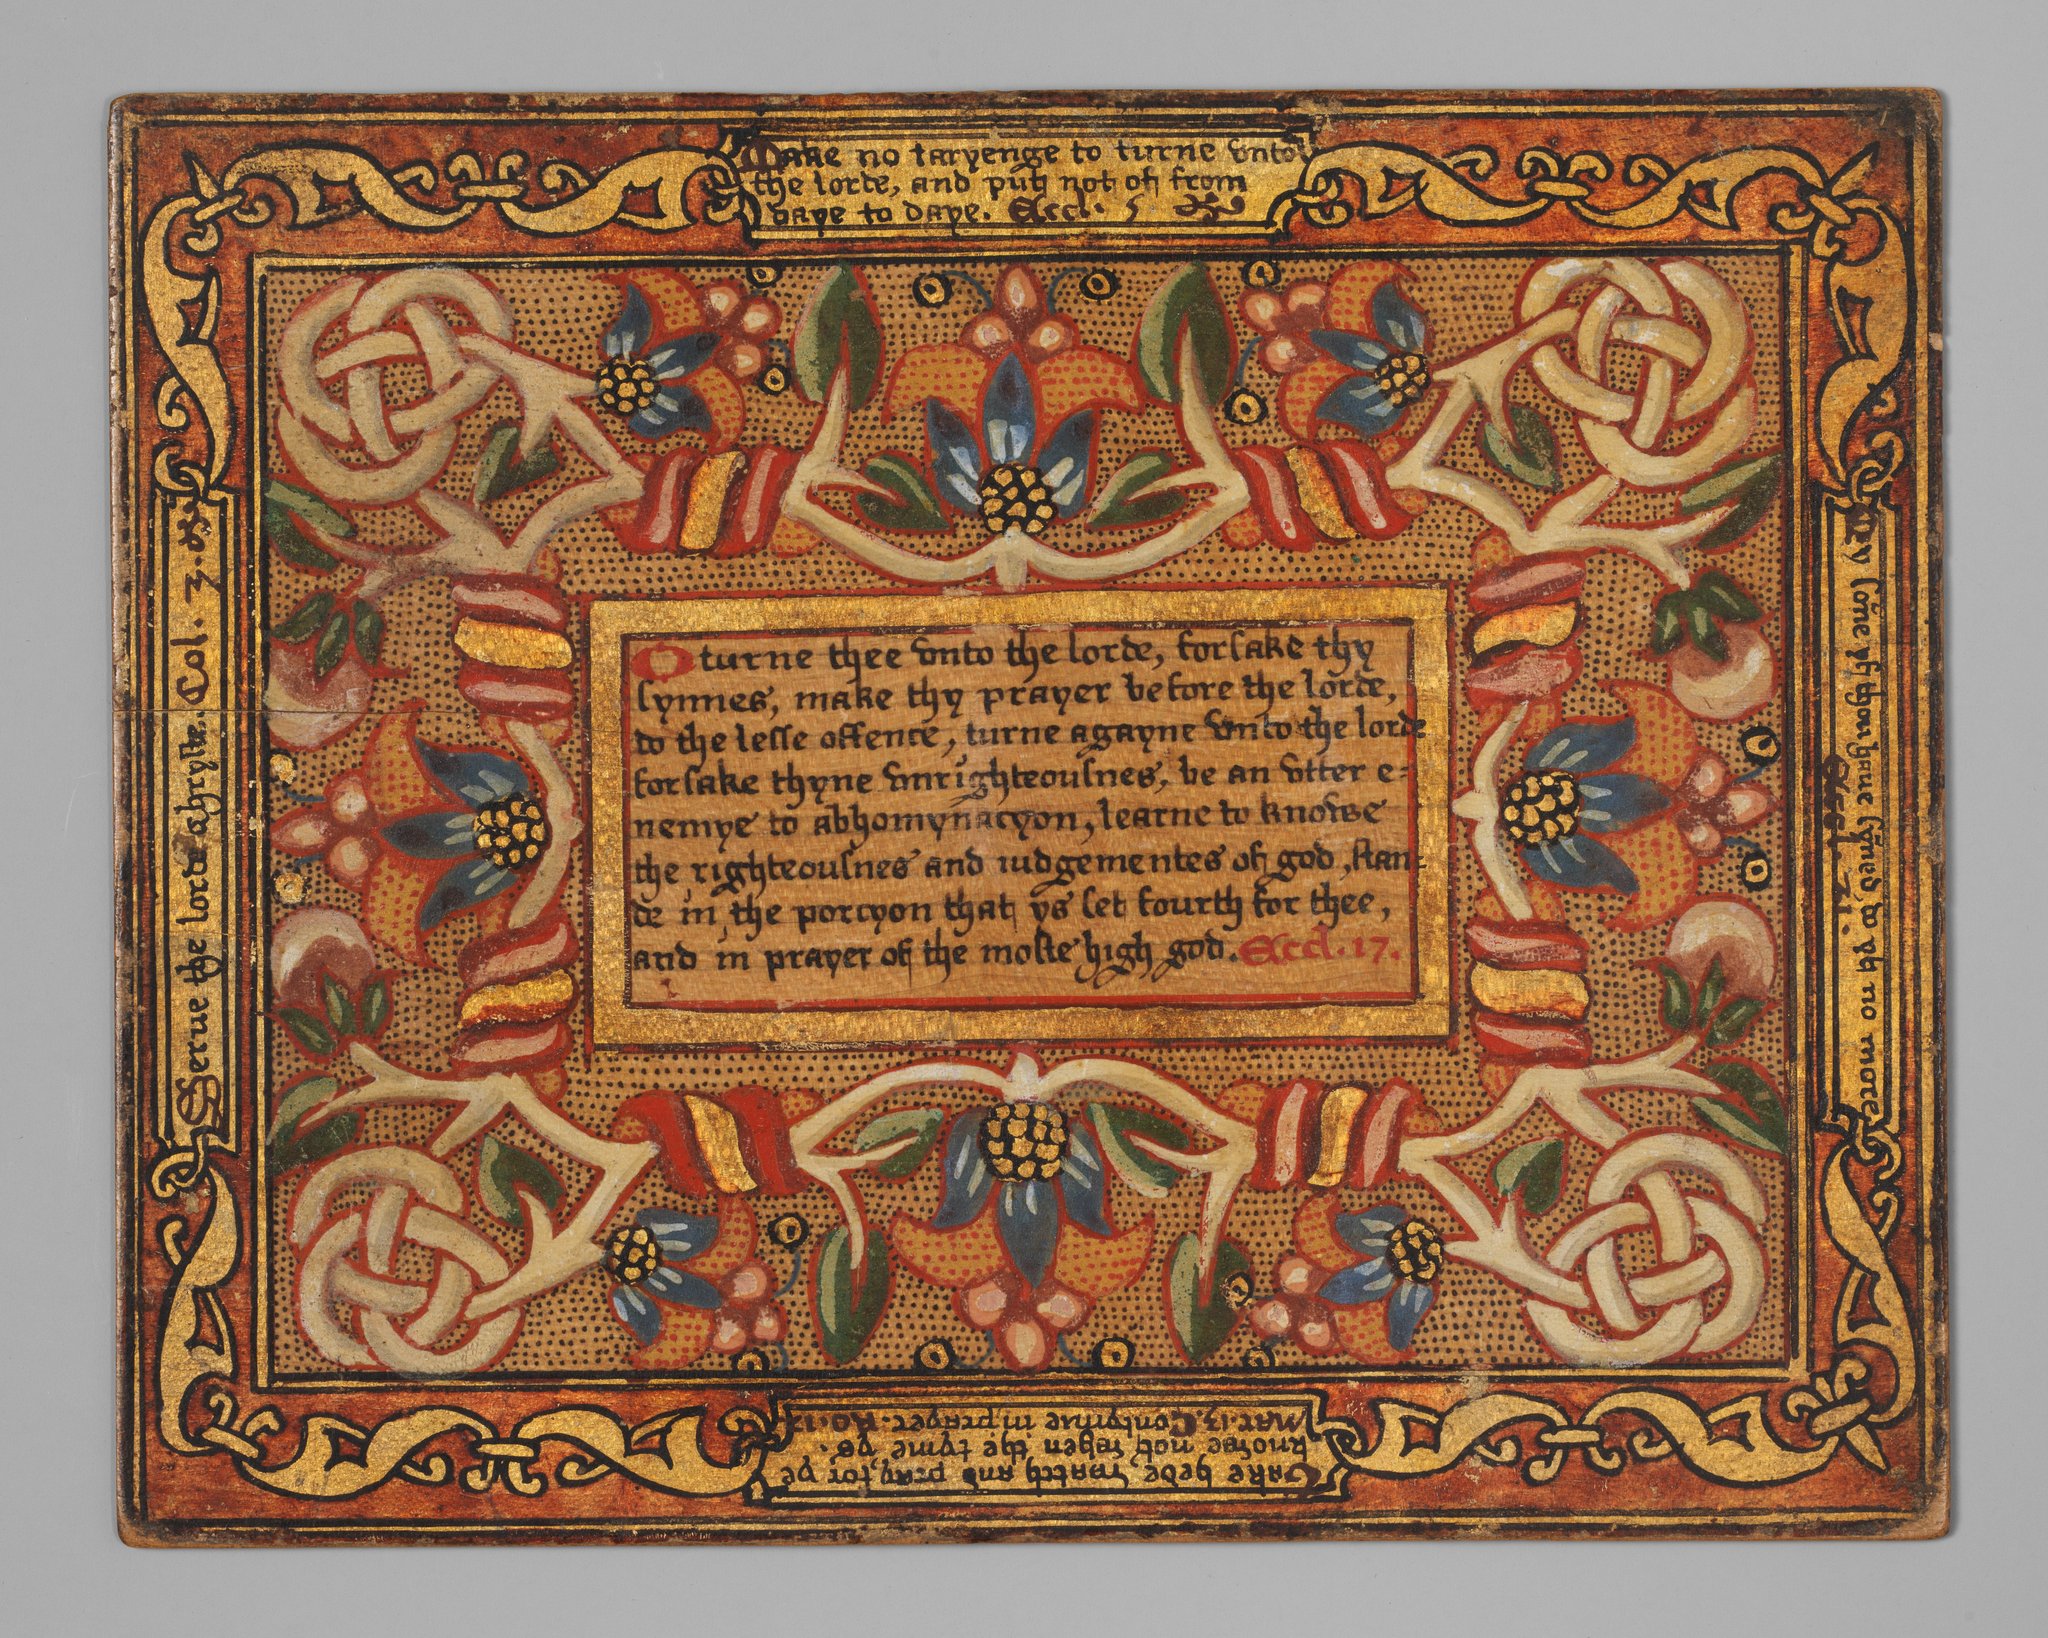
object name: trencher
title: Trencher with quotation from The Governance of Virtue (1566) (one of a set)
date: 1601-1633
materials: wood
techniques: gilding, painting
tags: flowers